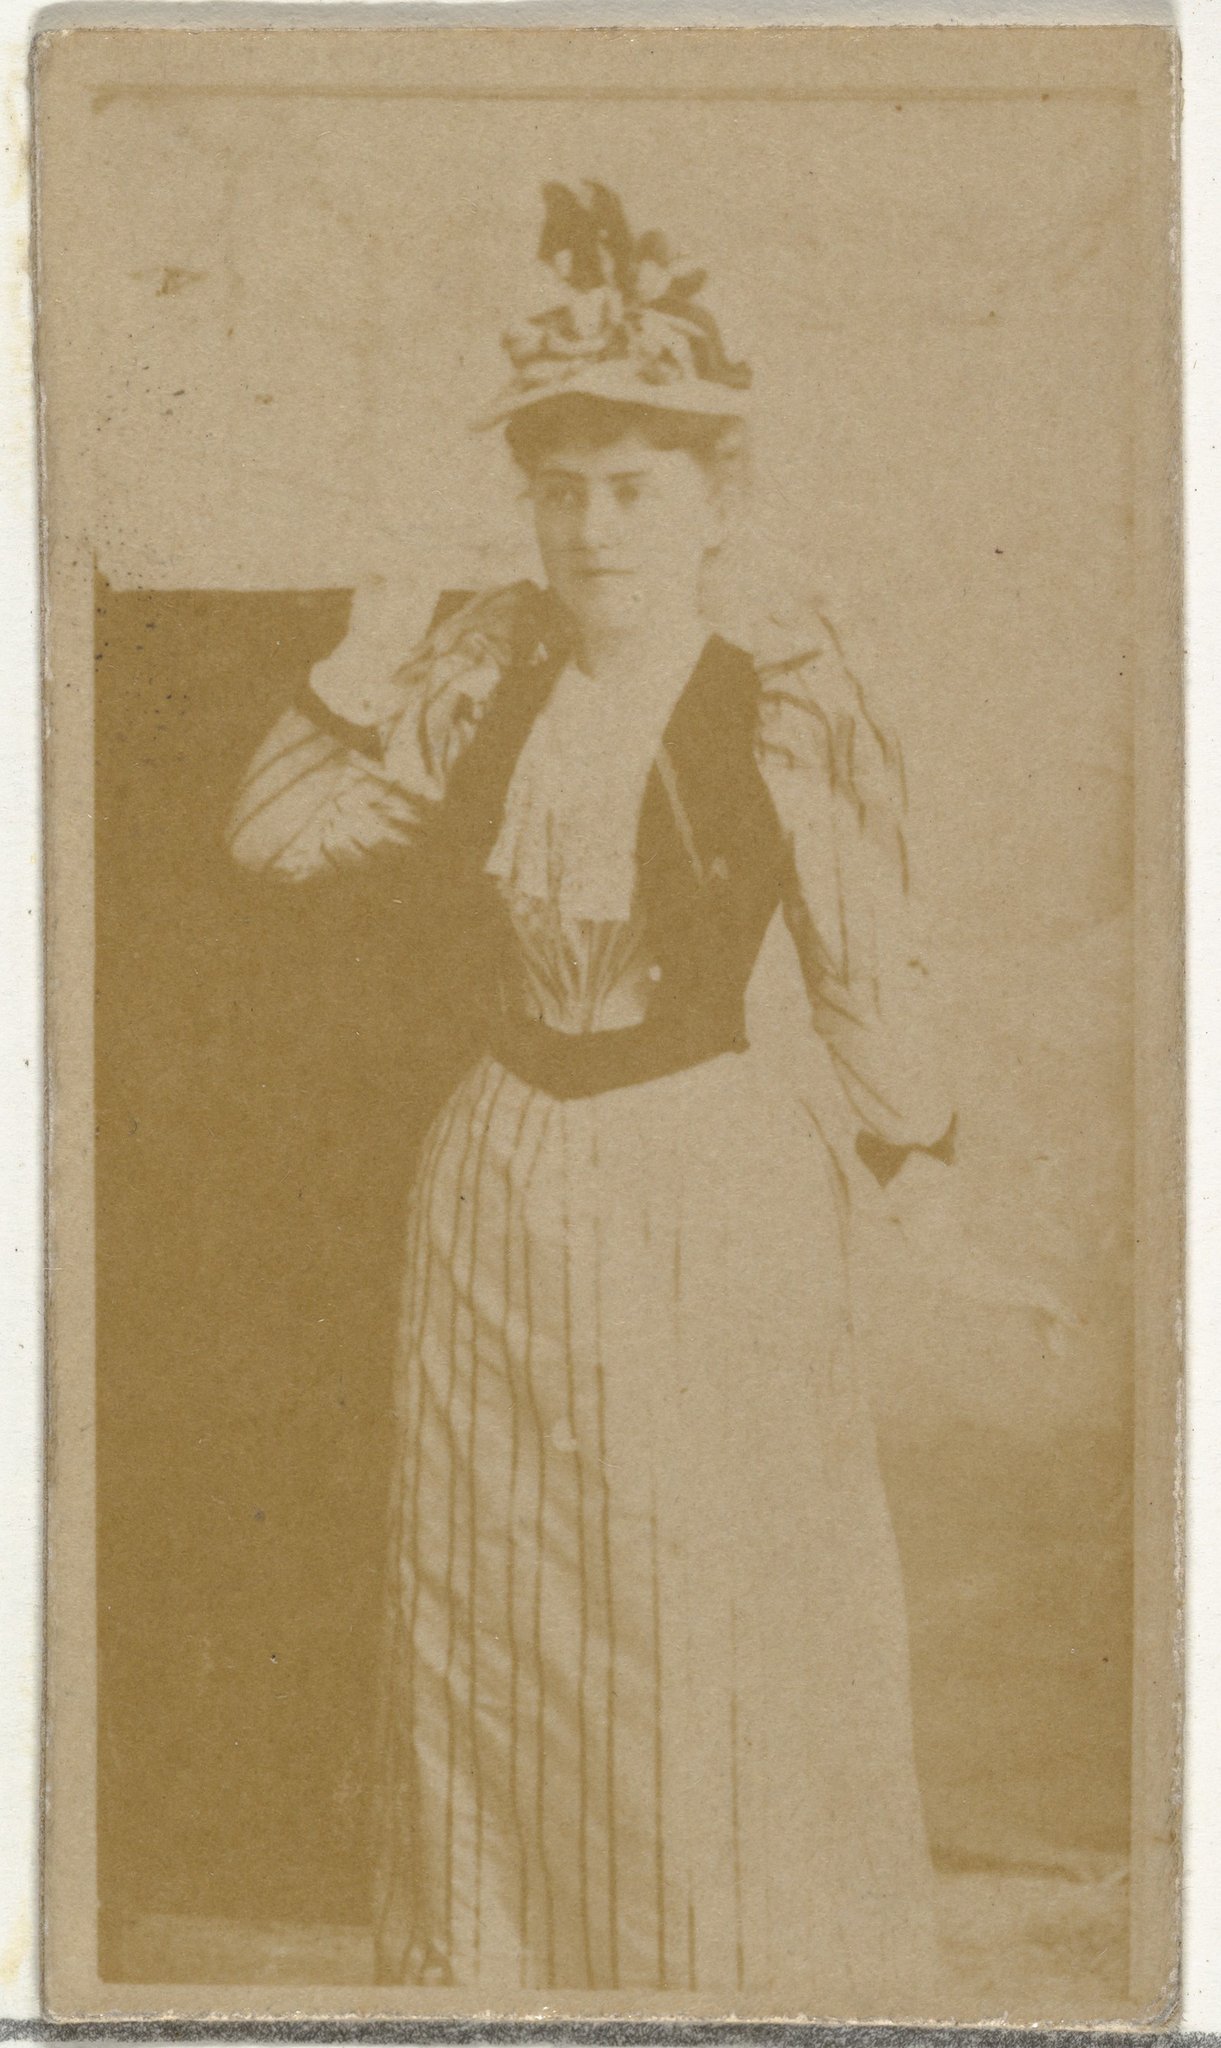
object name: photograph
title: [Actress wearing dress with vertical striped pattern], from the Actors and Actresses series (N145-8) issued by Duke Sons & Co. to promote Duke Cigarettes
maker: w. duke, sons & co.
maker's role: publisher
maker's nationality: american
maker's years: 1870-1920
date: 1891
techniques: albumen silver print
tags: portraits,women,actresses